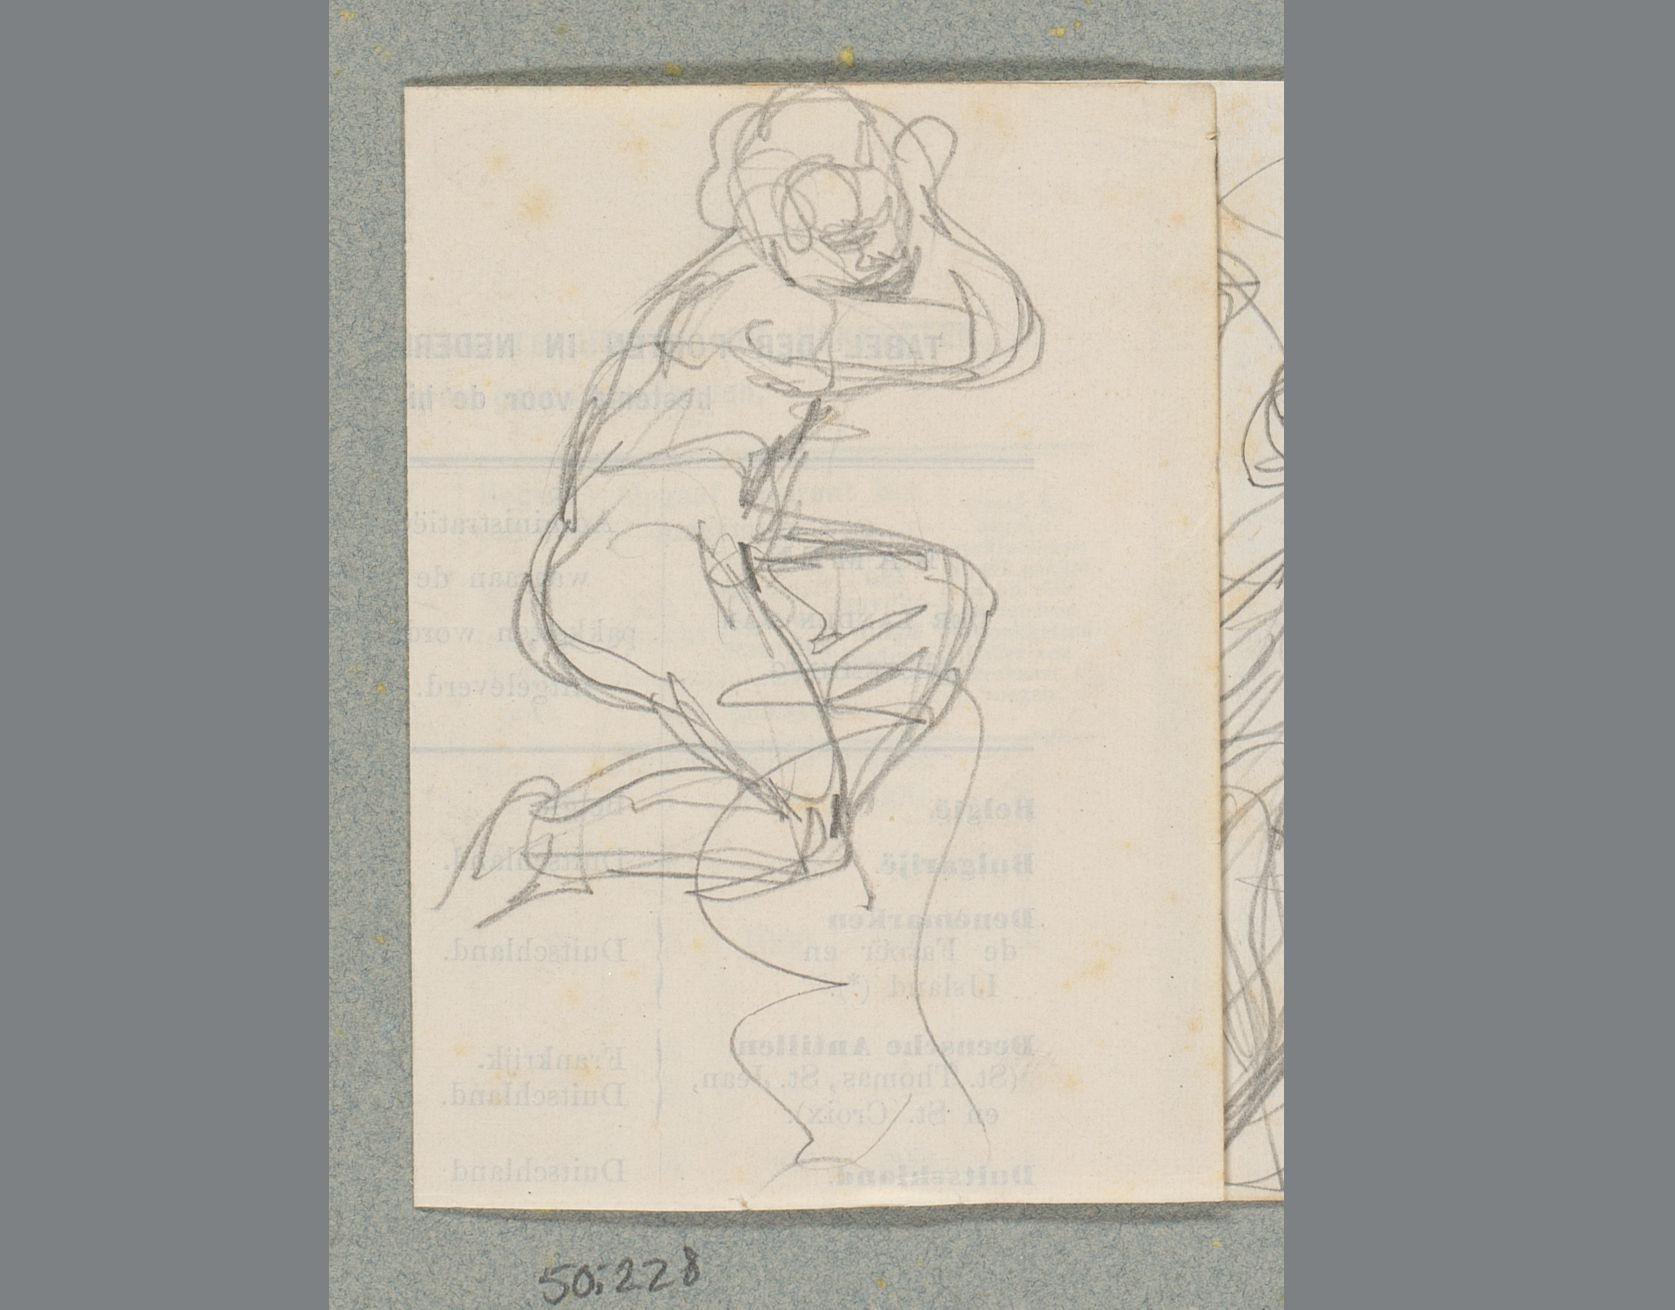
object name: drawing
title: Figuurstudie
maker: august allebé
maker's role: draughtsman, print maker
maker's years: 1838-1927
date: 1848-1927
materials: paper, pencil